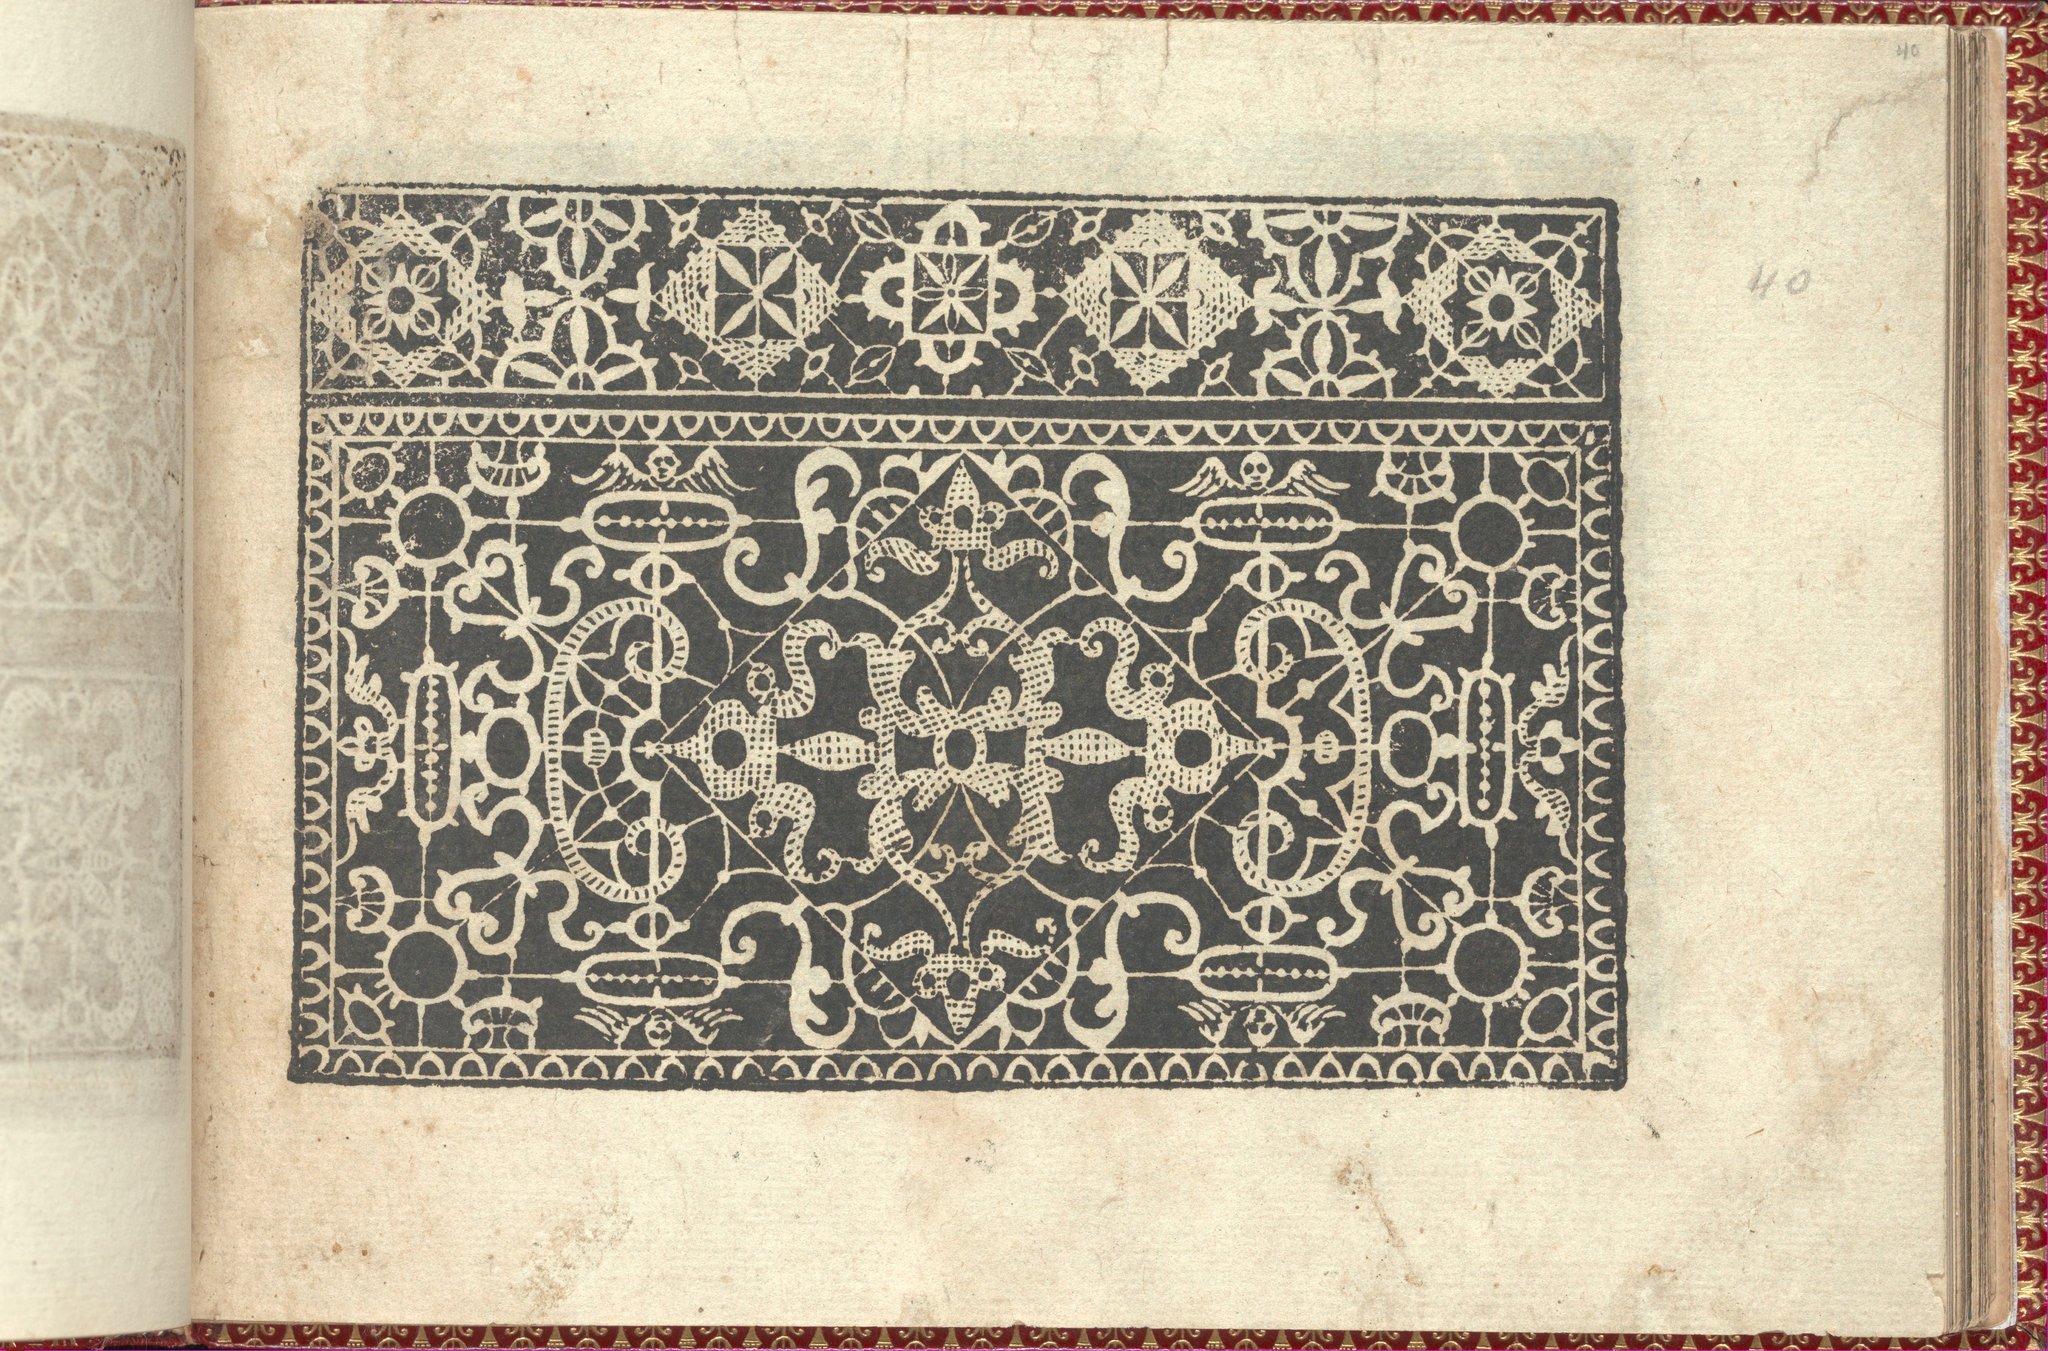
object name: book print ornament architecture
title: Corona delle Nobili et Virtuose Donne: Libro I-IV, page 40 (recto)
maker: cesare vecellio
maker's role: publisher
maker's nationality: italian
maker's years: 1521-1601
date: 1601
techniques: woodcut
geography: italy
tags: ornament